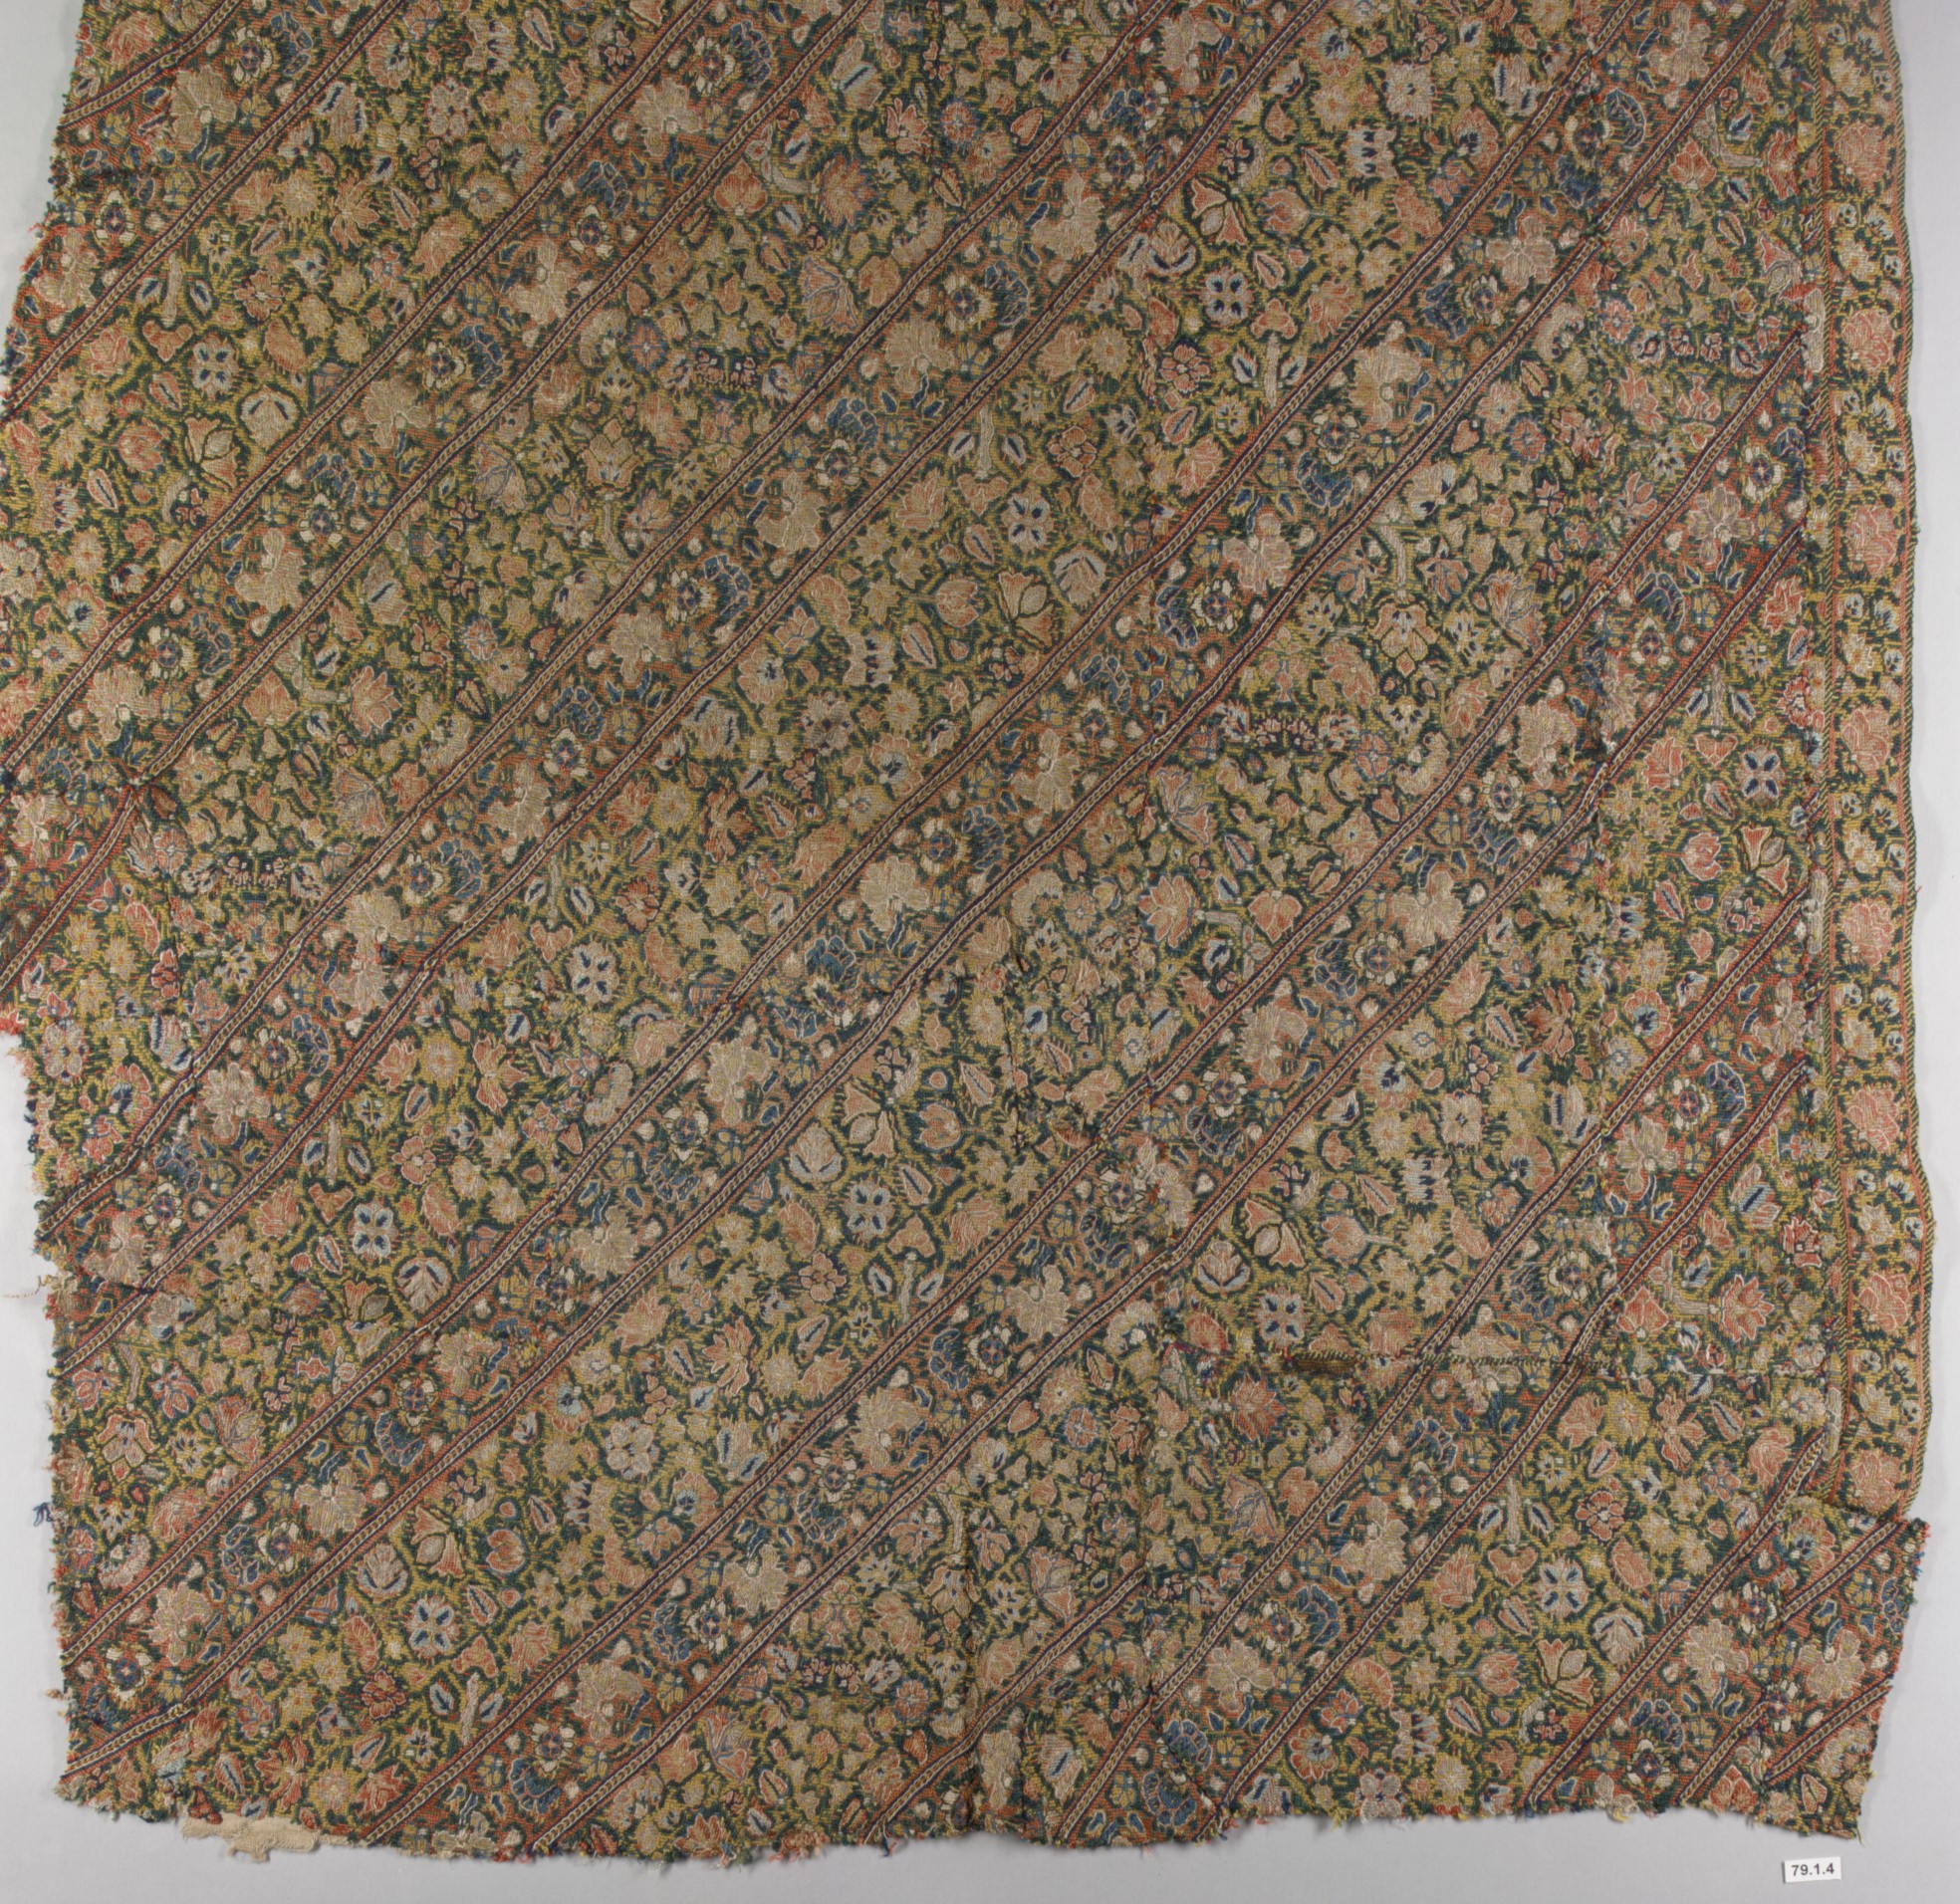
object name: fragment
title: Textile Fragment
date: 1767-1833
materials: linen, silk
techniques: embroidery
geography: iran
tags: flowers